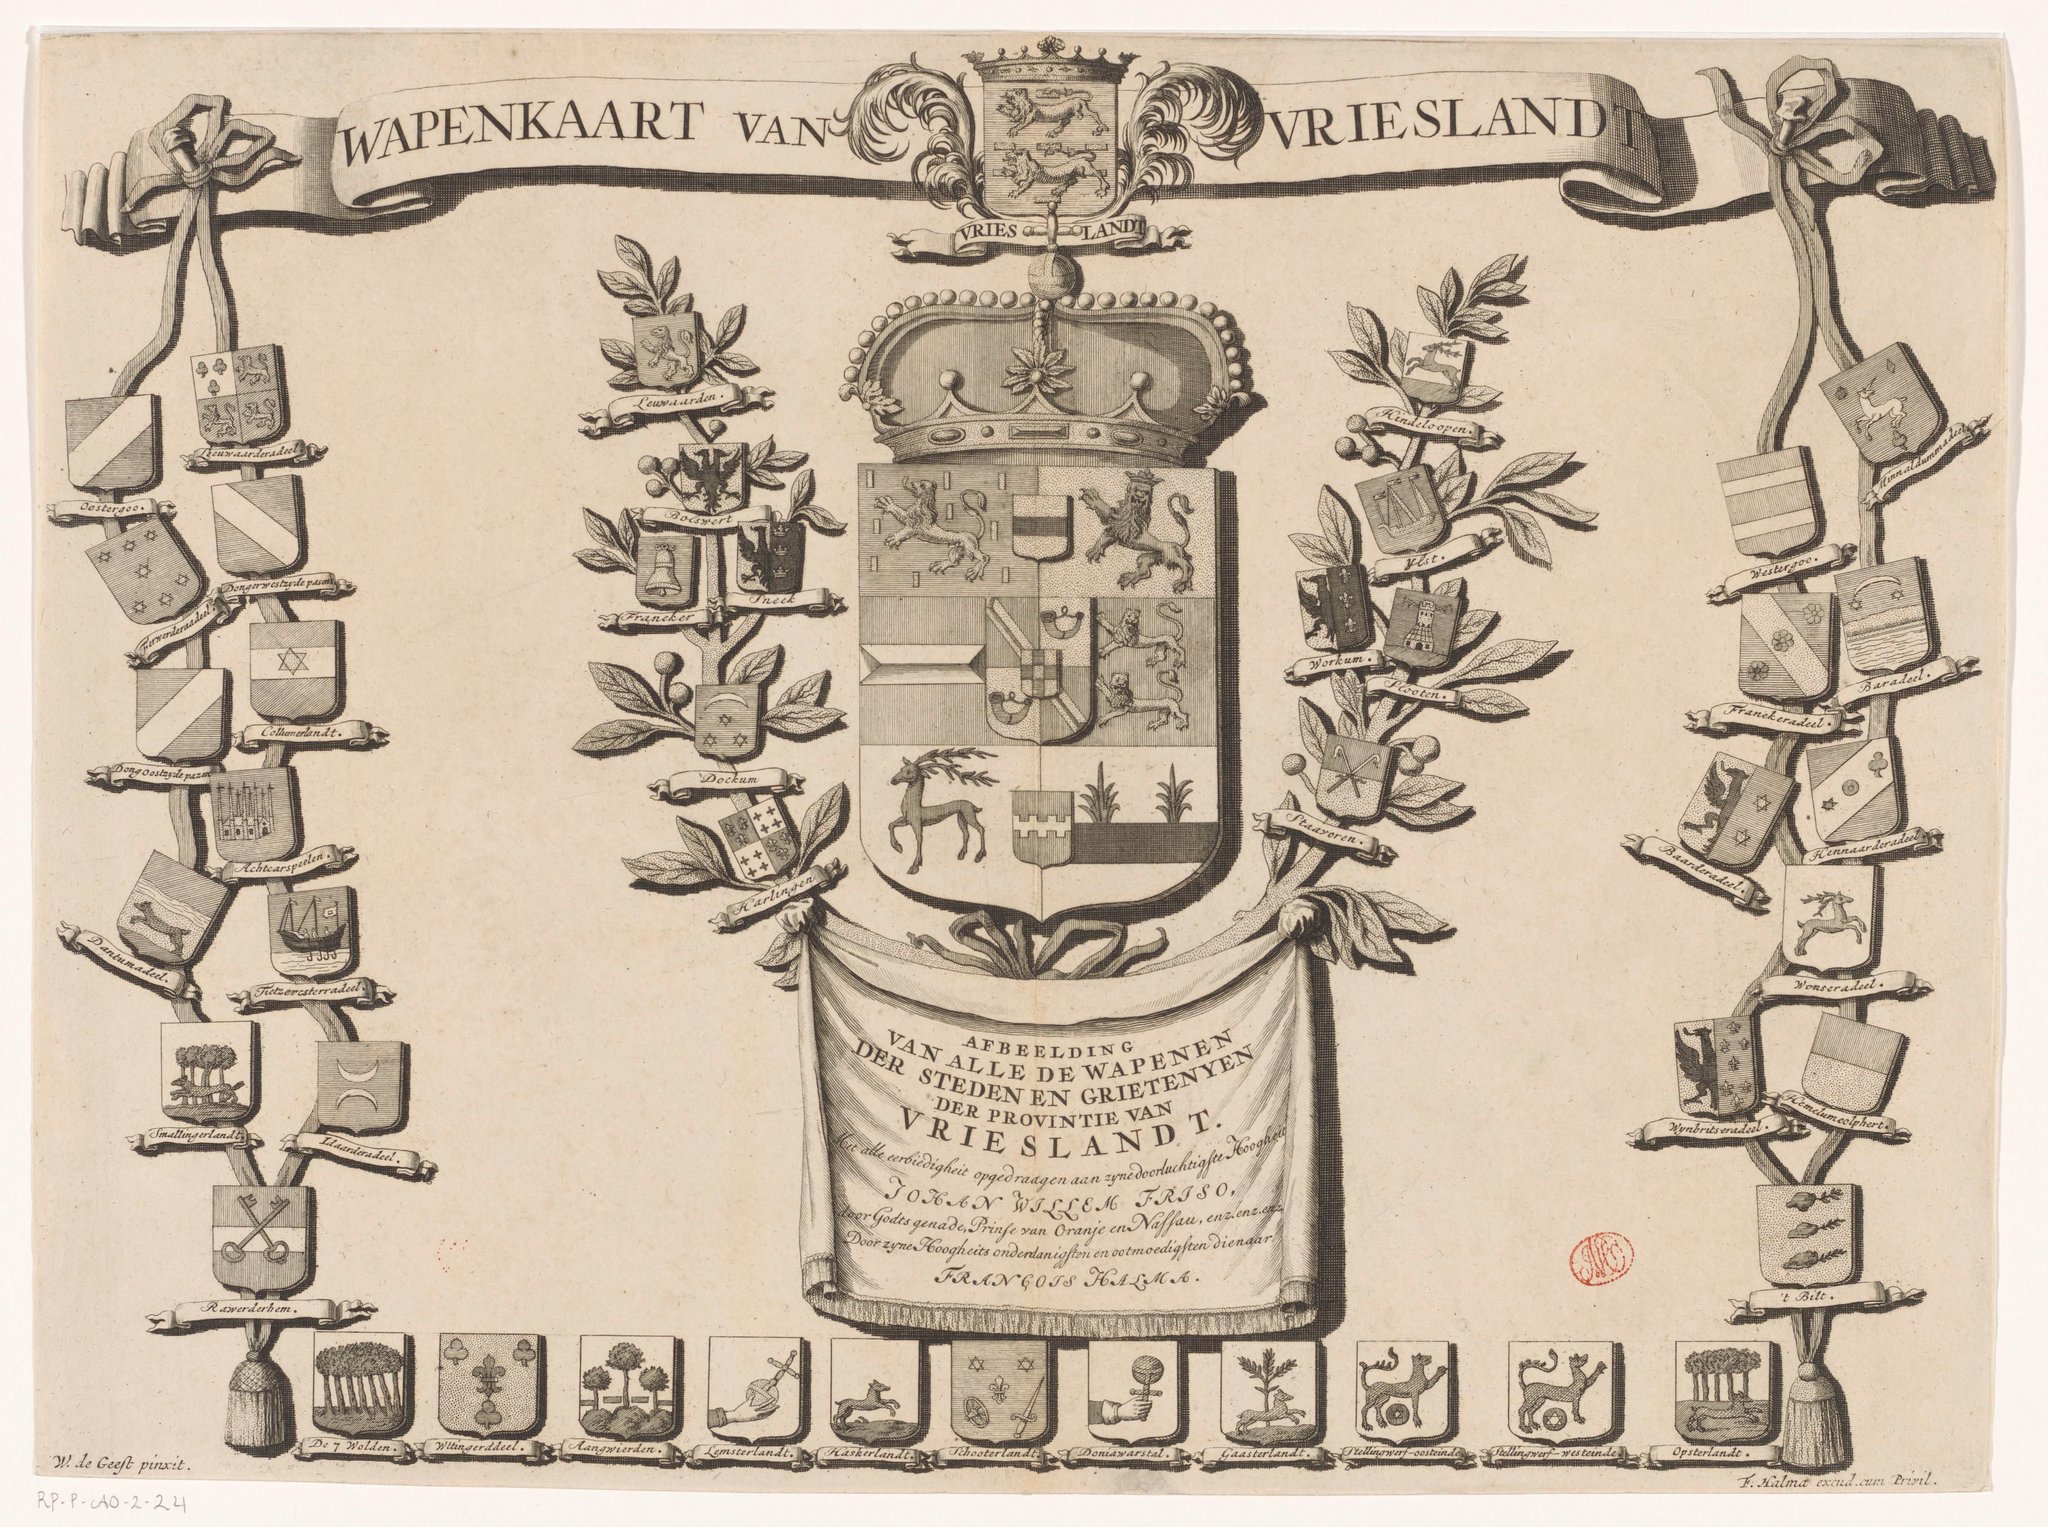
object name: map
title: Wapenkaart van Friesland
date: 1702-1711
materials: paper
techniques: engraving, etching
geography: leeuwarden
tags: johan willem friso (prins van oranje-nassau), coat of arms (as symbol of the state, etc.), maps of separate countries or regions, harlingen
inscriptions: collector's mark: Lugt 195, collector's mark: Lugt 2228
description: In het midden het wapen van Johan Willem Friso, prins van Oranje-Nassau, daarboven het wapen van Friesland. Daaromheen de wapens van Friese steden. Links de wapens van het kwartier Oostergo en bijhorende grietenijen. Onderaan de wapens van het kwartier Zevenwouden en bijhorende grietenijen. Rechts de wapens van Westergo en bijhorende grietenijen.